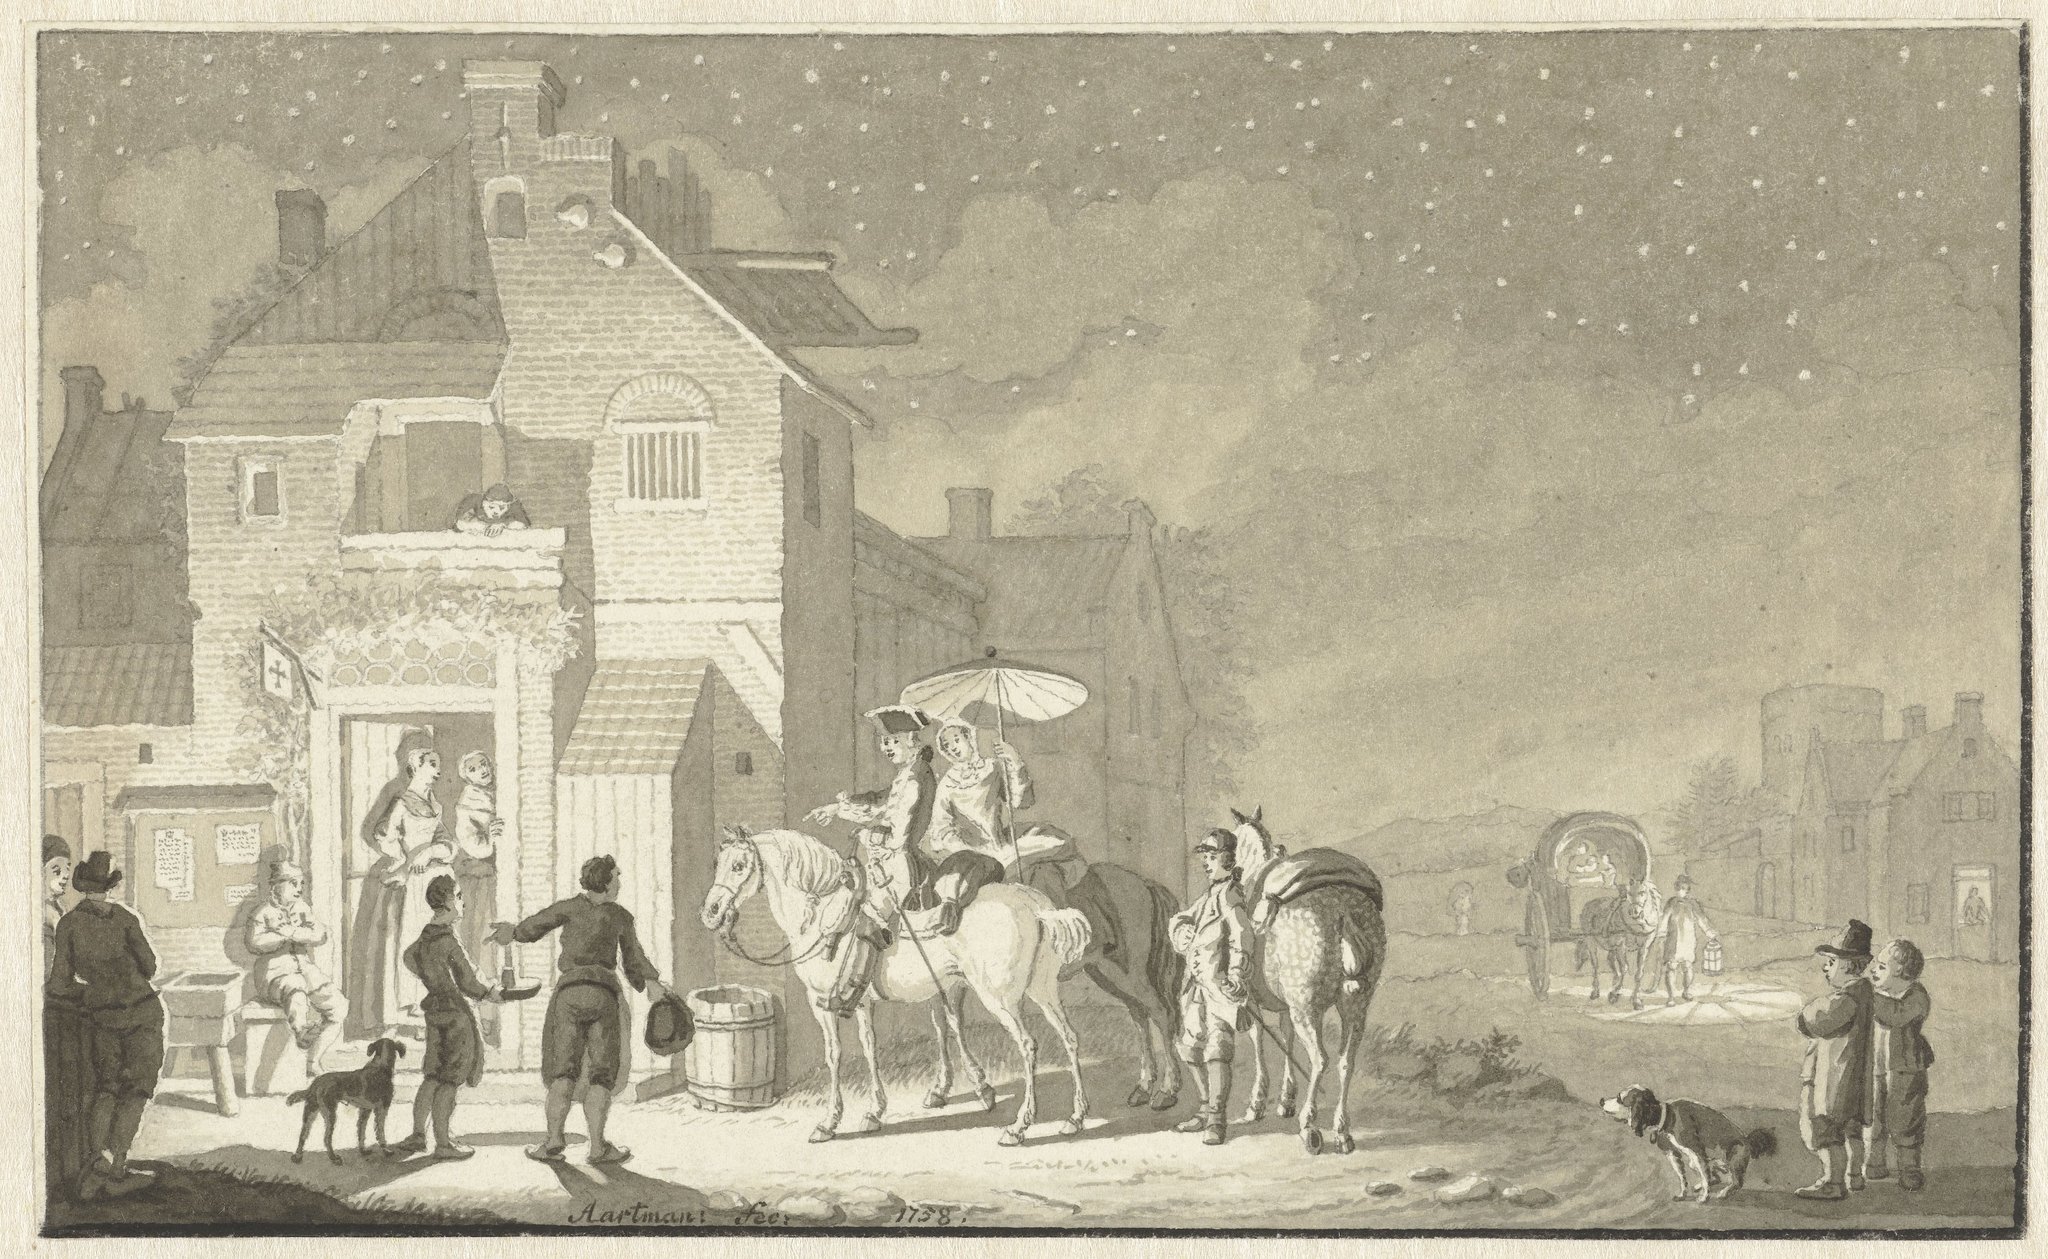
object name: drawing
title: Reisgezelschap voor herberg bij avond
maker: nicolaes aartman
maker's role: draughtsman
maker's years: 1713-1760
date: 1758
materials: paper, pencil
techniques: brush